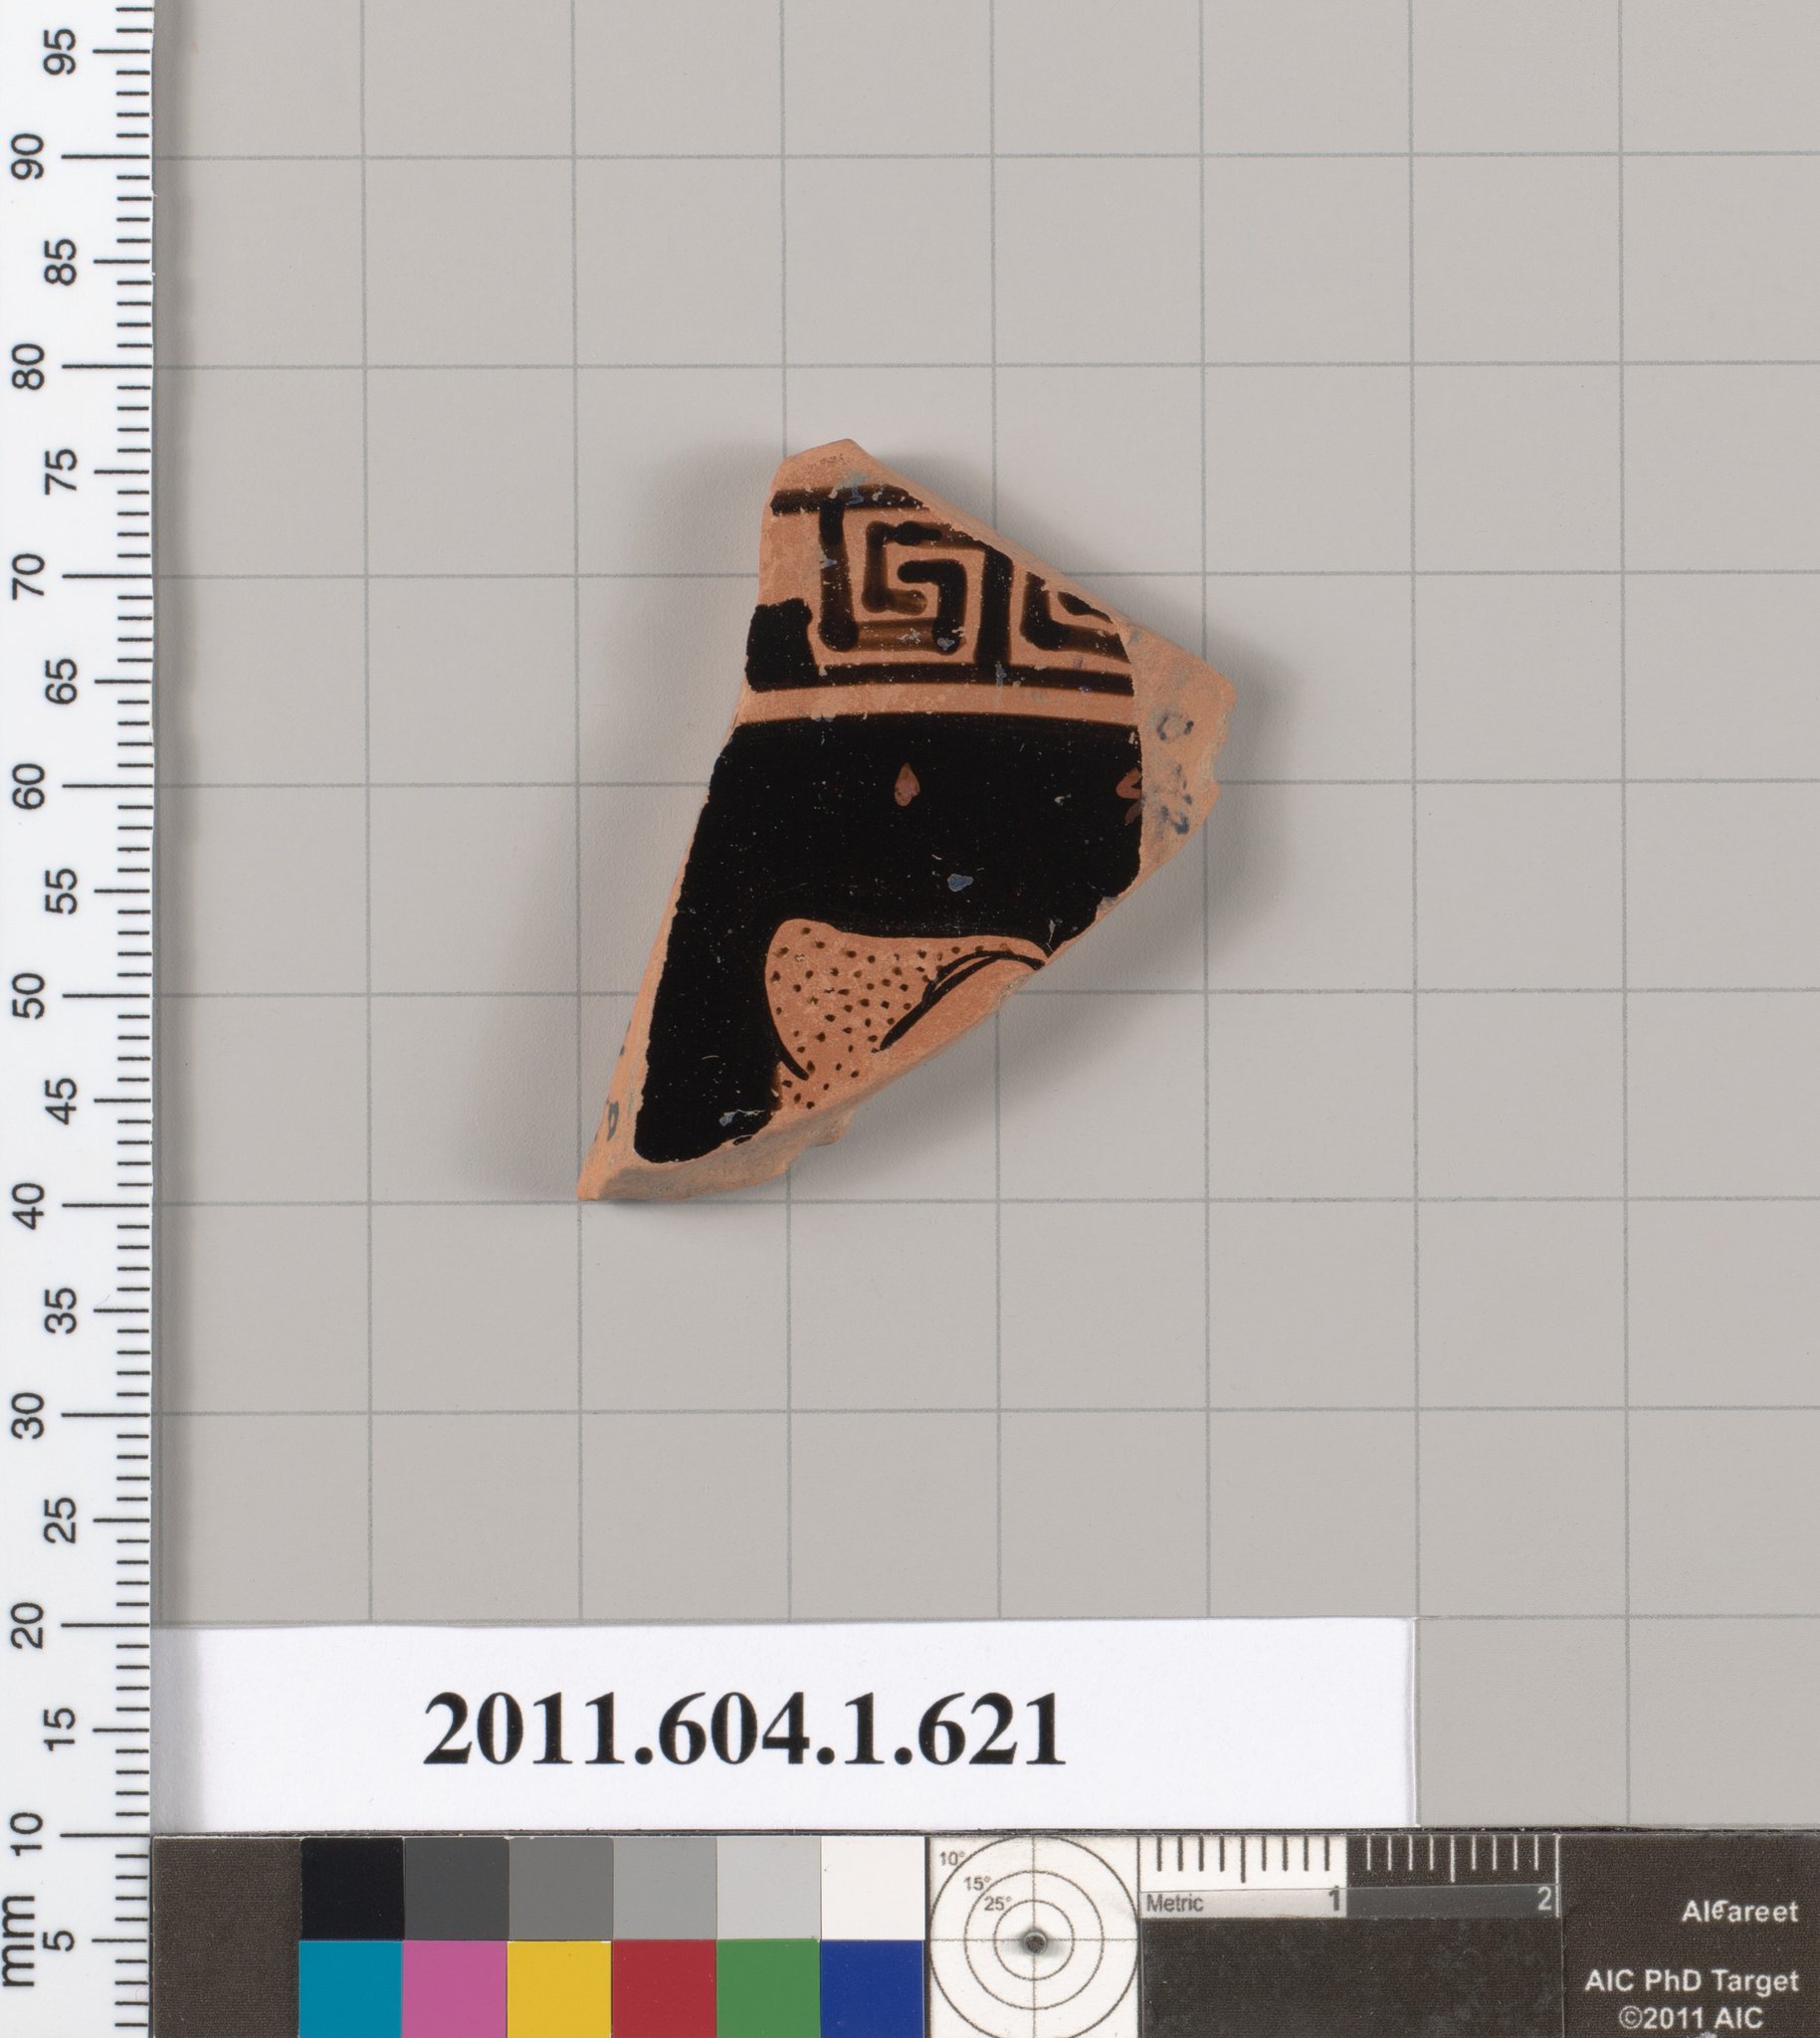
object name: kylix fragment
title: Terracotta fragment of a kylix (drinking cup)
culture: greek, attic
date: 475-451 BCE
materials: terracotta